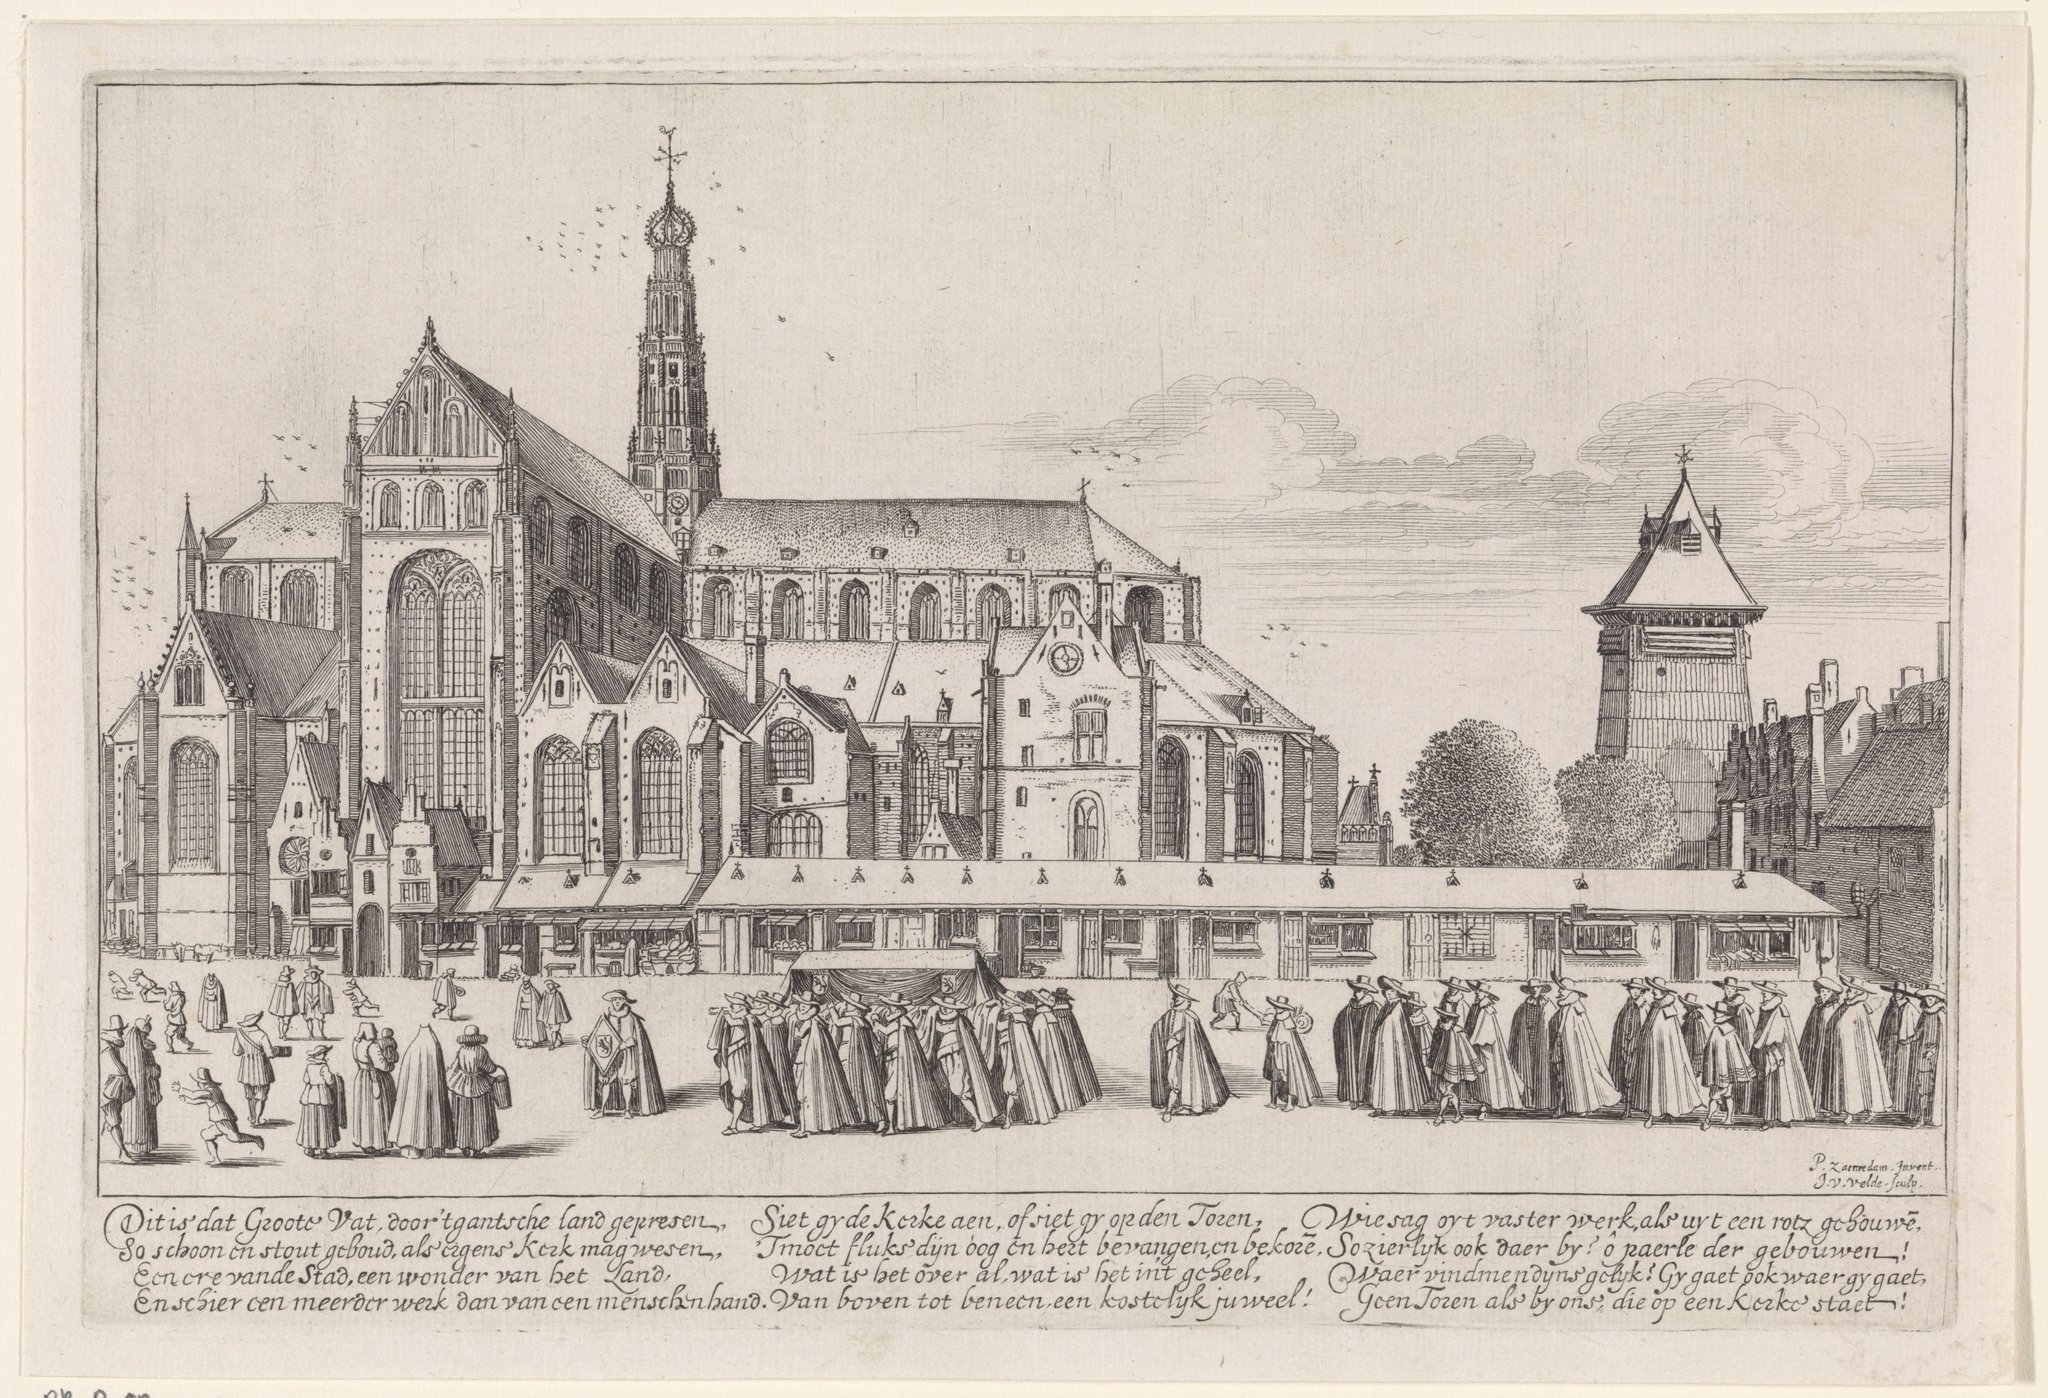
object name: print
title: Gezicht op de Sint-Bavokerk, vanuit het zuidoosten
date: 1628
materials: paper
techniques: engraving, etching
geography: haarlem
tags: church (exterior), public funeral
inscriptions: collector's mark: Lugt 240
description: Prent ook gebruikt in: Ampzing, Samuel. Beschryvinge ende lof der stad Haerlem in Holland […]. Haarlem: Adriaen Roman (I), 1628.